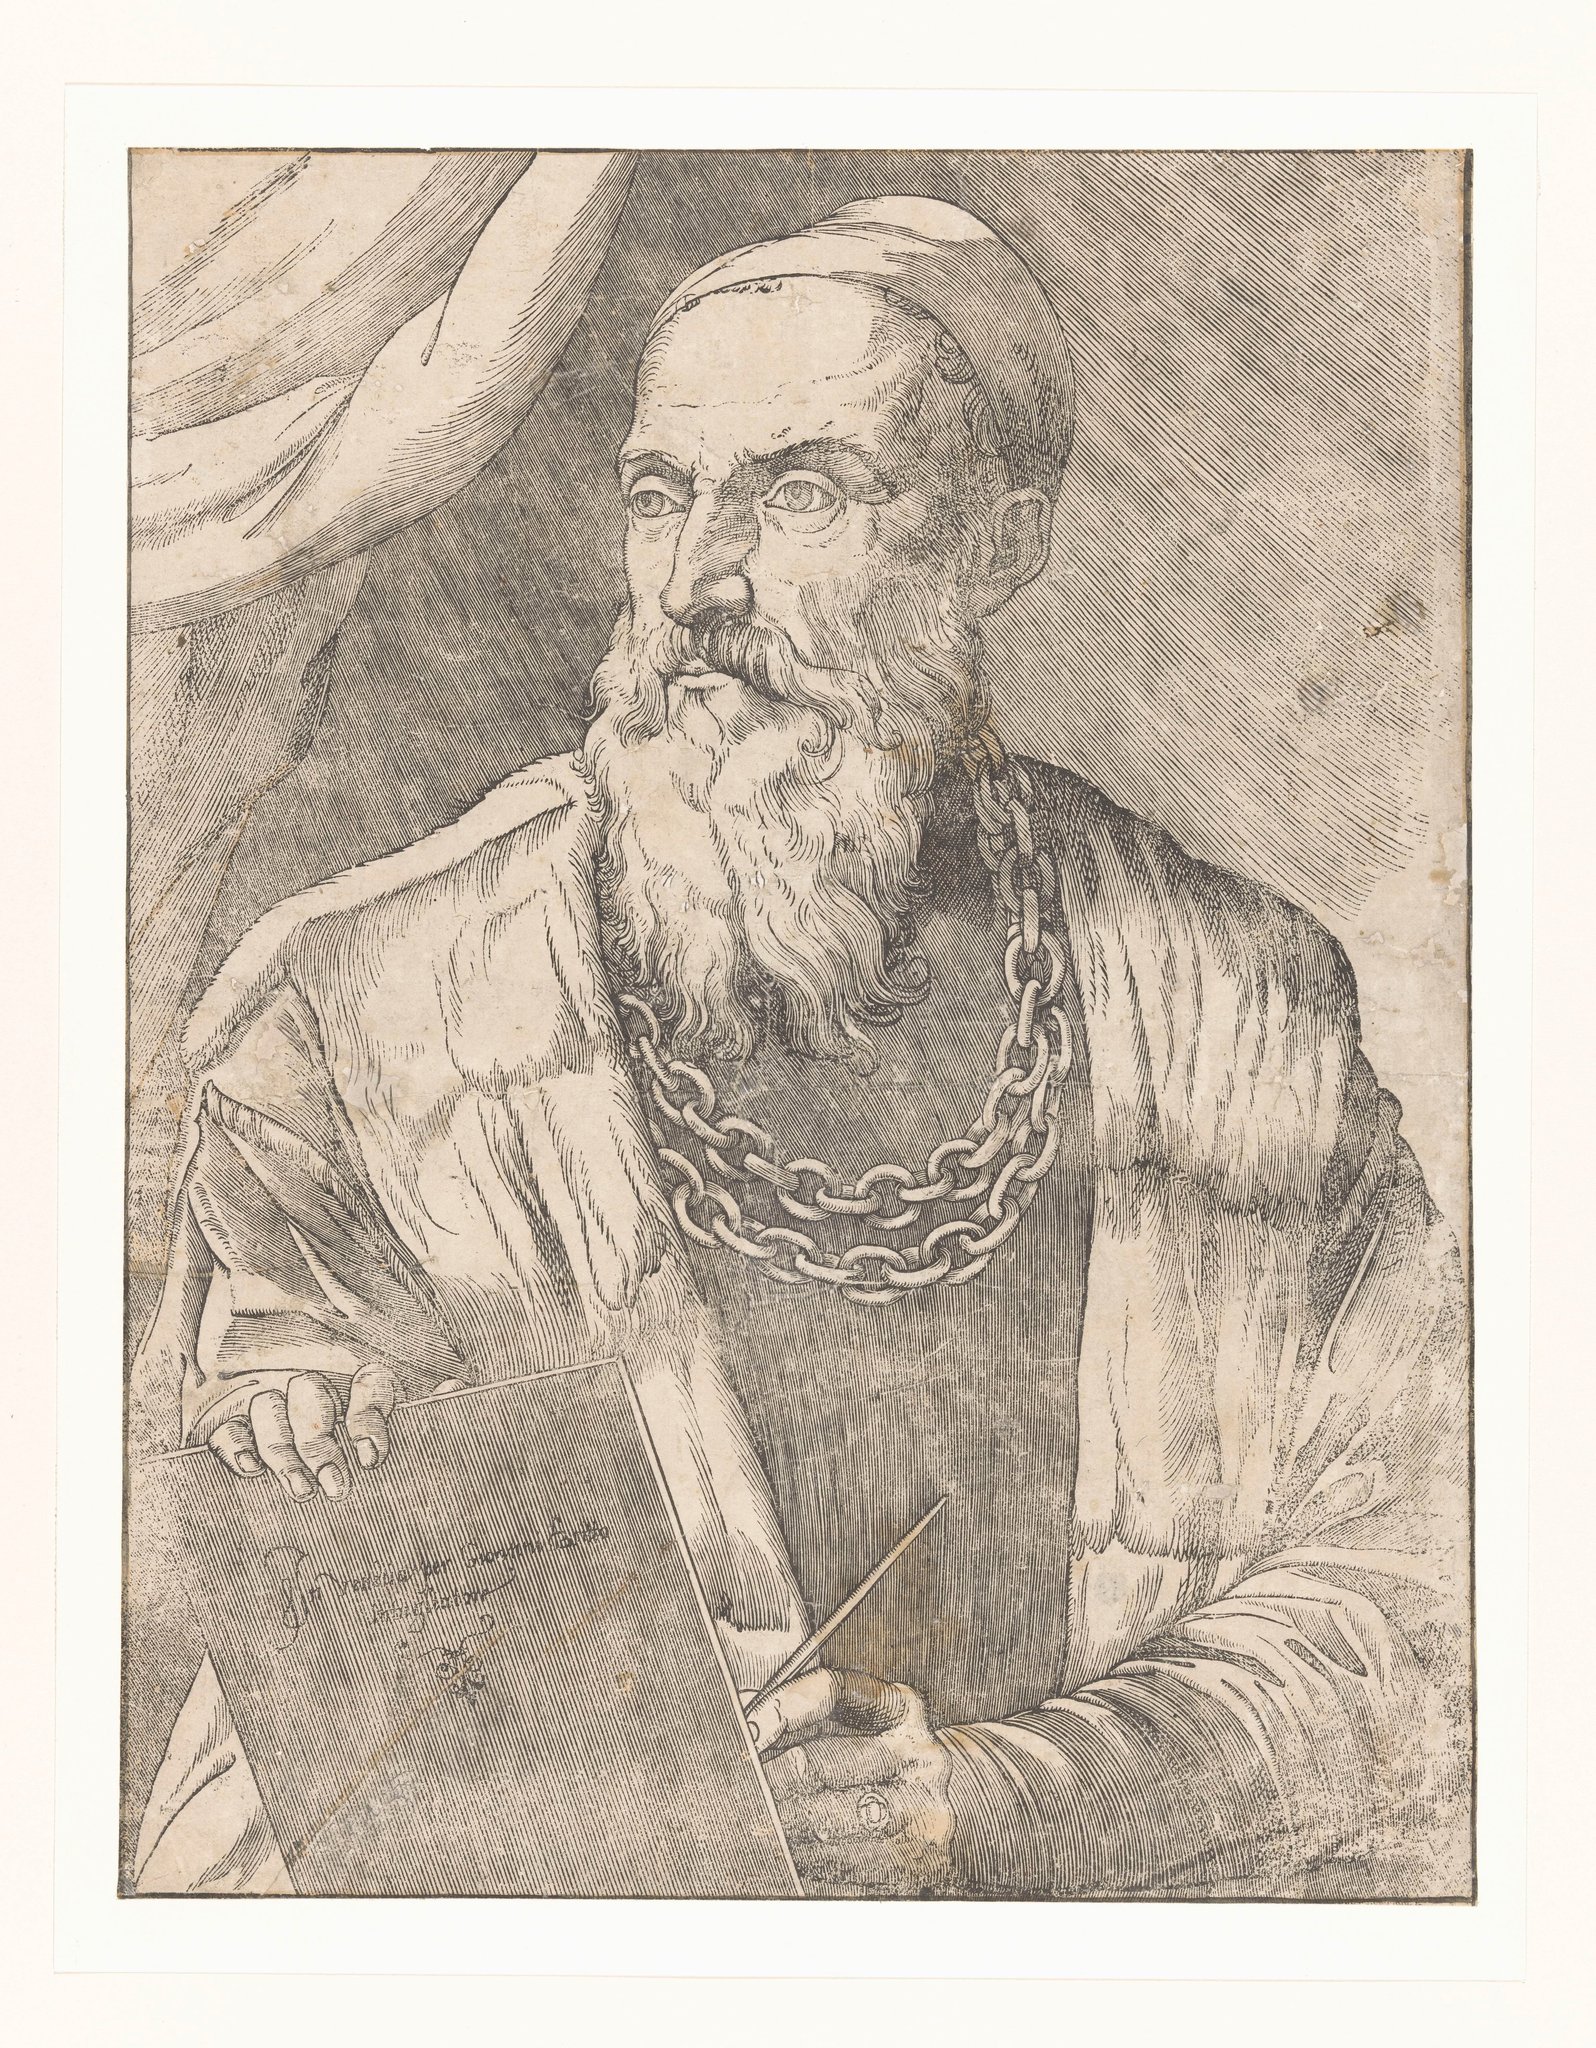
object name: print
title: Portret van kunstenaar Titiaan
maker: giovanni britto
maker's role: print maker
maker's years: 1500-1550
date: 1550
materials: paper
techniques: woodcut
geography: venice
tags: venice, painter, draughtsman, titiaan, historical persons, portrait, self-portrait of painter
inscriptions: collector's mark: Lugt 2228